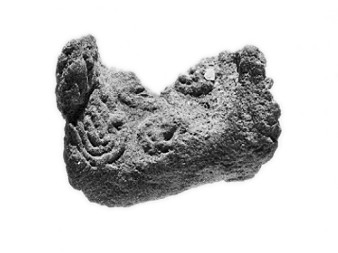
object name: sealing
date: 1981-1640 BCE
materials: mud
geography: egypt